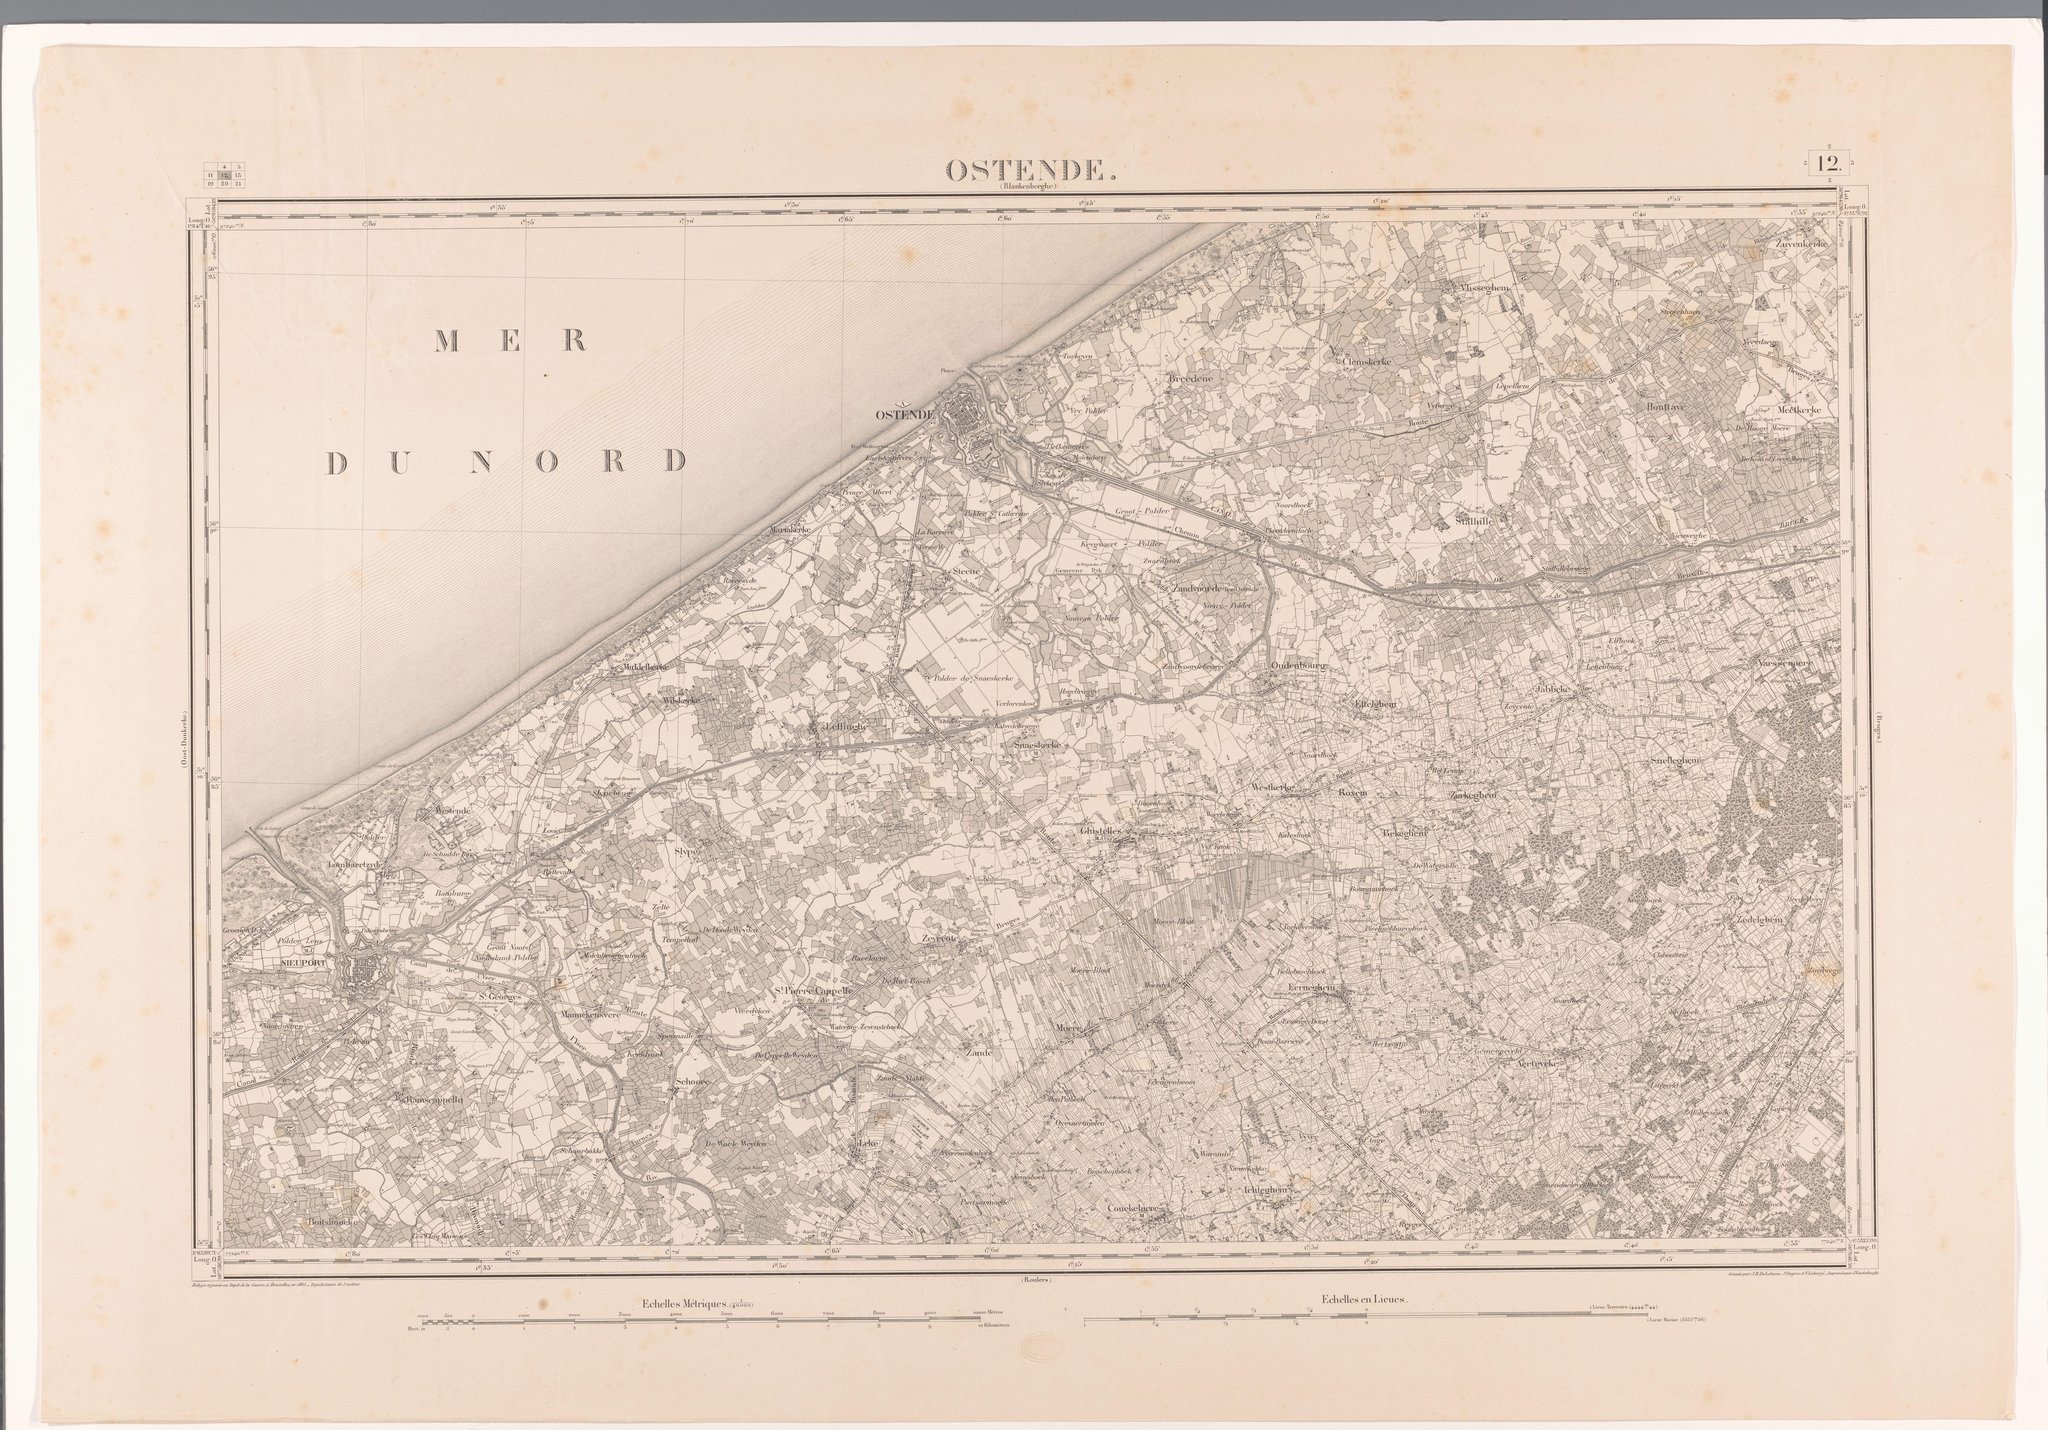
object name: print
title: Ostende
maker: j. vanderborght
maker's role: printer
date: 1865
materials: paper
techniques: lithograph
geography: brussels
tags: maps of separate countries or regions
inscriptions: check stamp: ‘Depot de la Guerre Belgique’